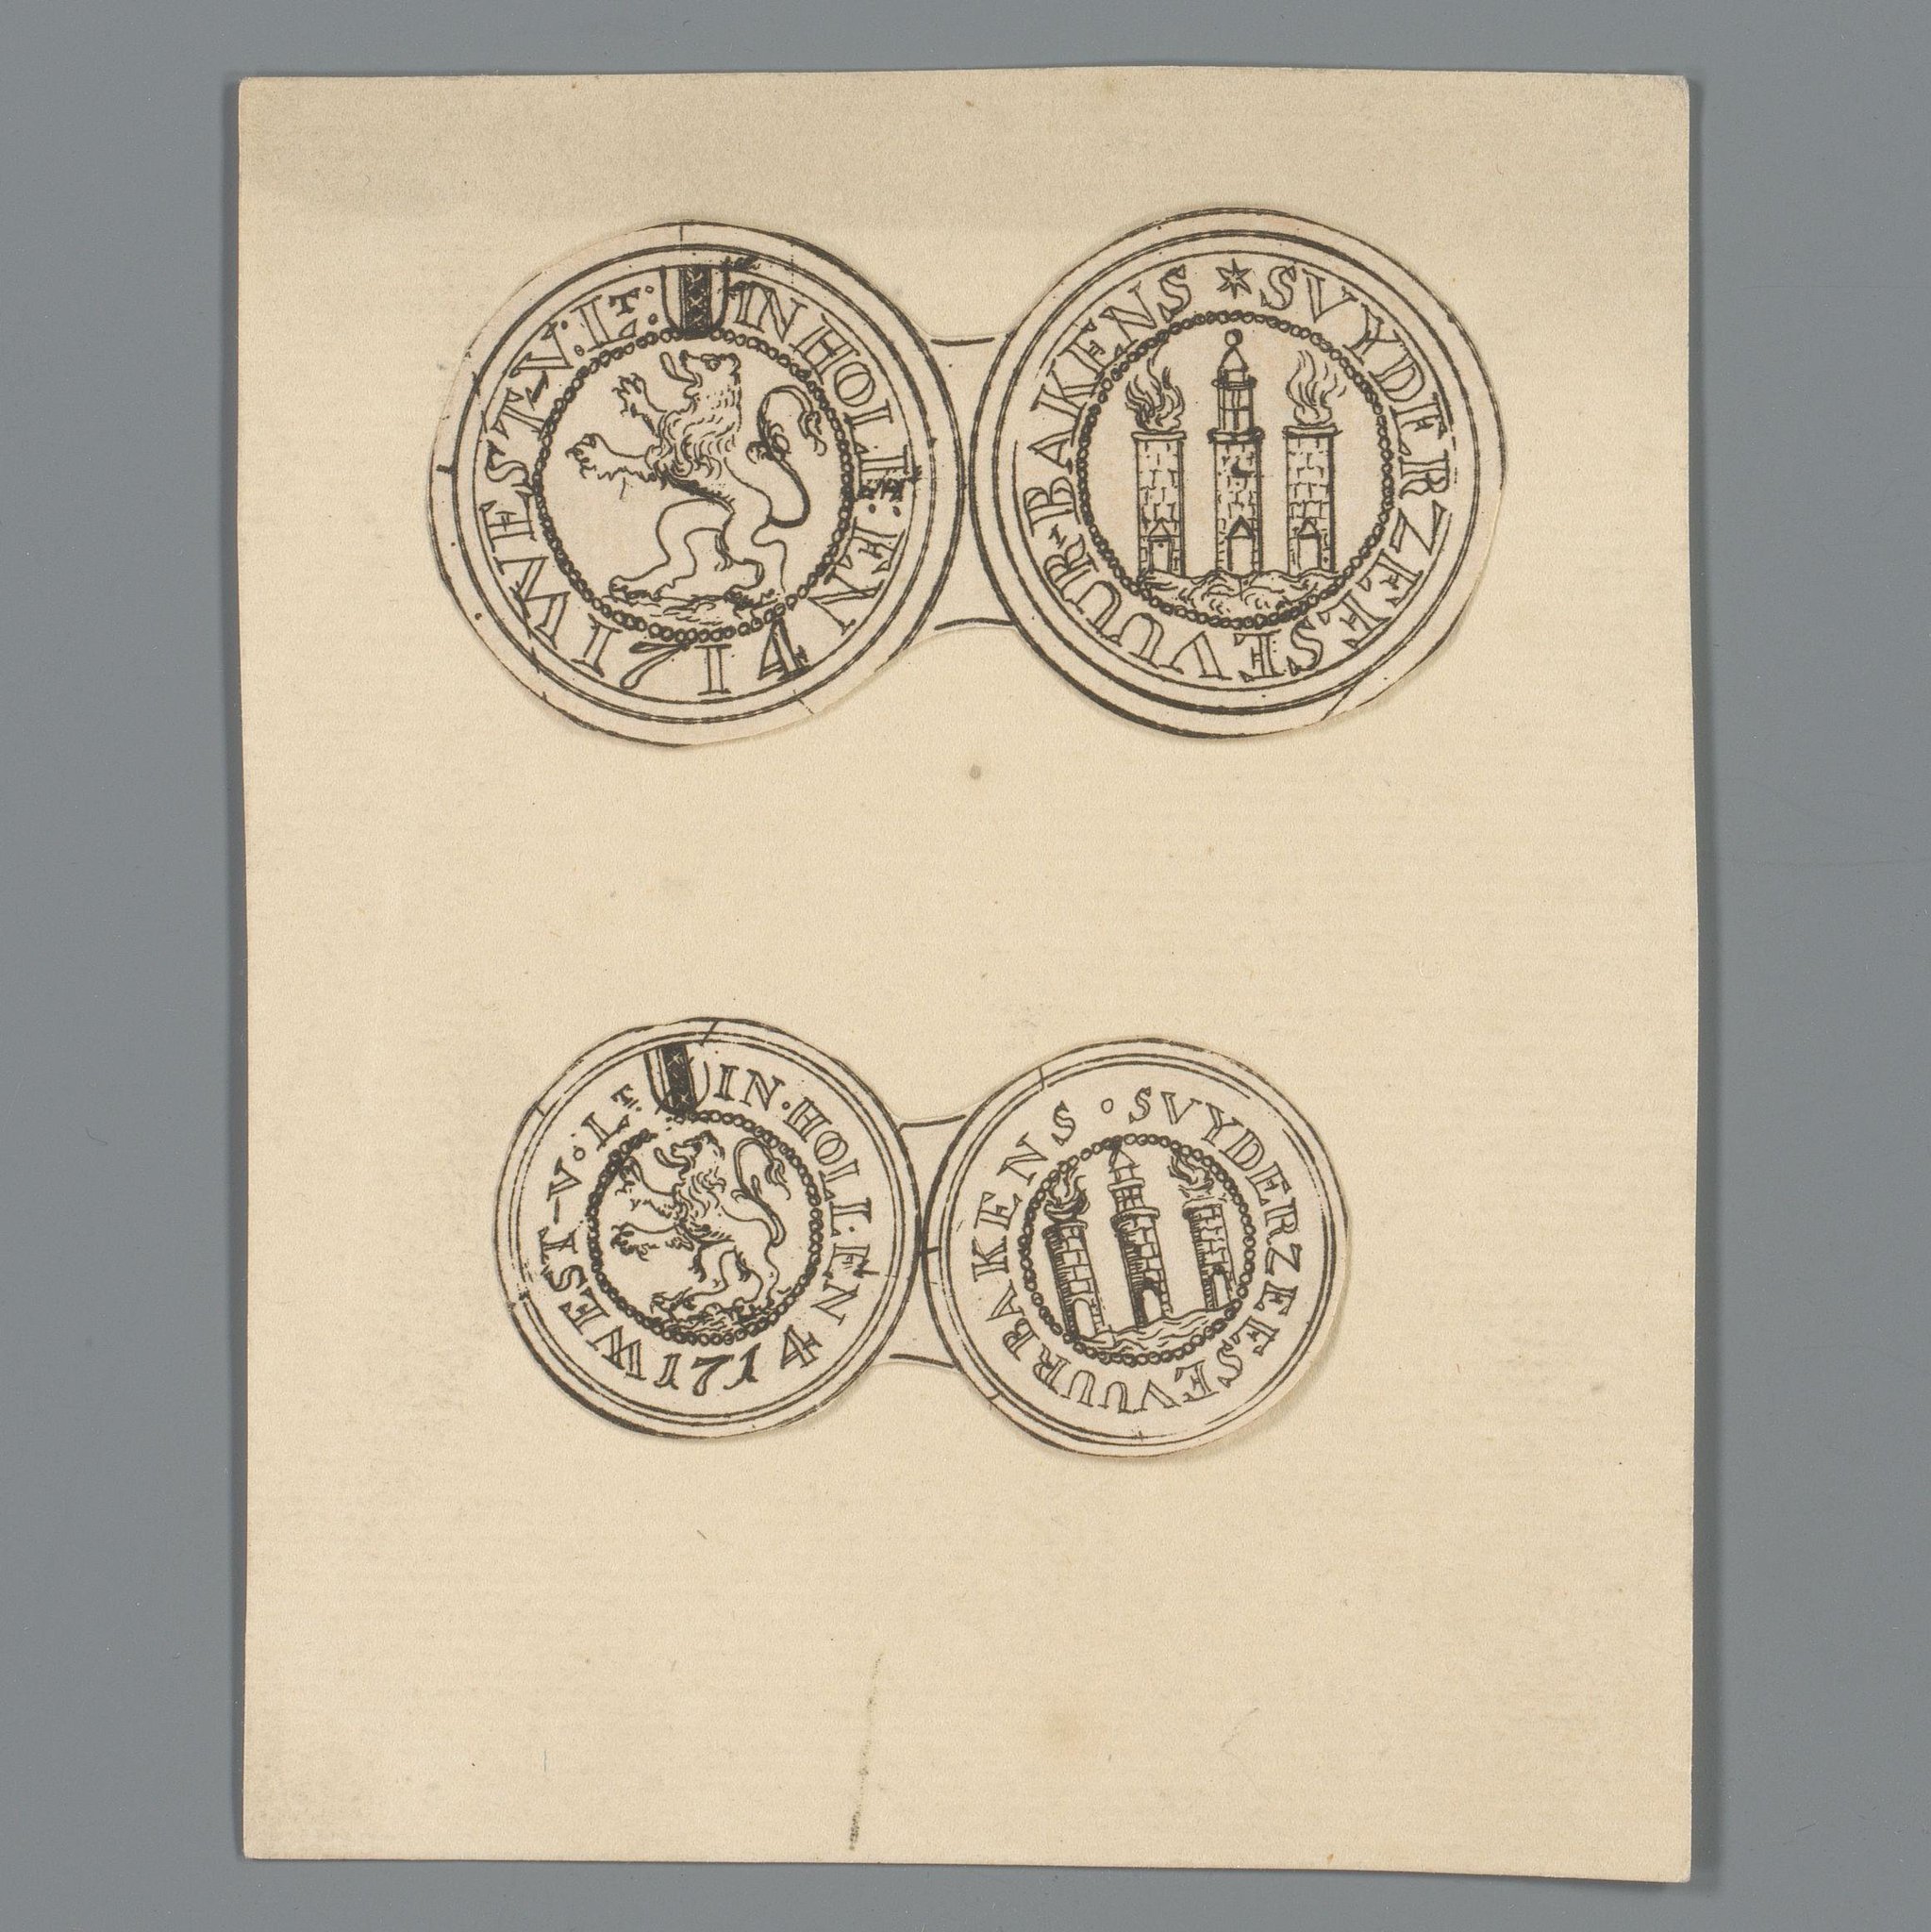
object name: bakenlood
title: Voor- en achterzijden van twee penningen (bakenloden) met hierop een leeuw, het wapen van Amsterdam en drie vuurbakens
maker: Anonymous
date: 1714-1850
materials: paper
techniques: etching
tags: lighthouse, lightship, politician, e.g. party leader, coin, amsterdam, zuiderzee